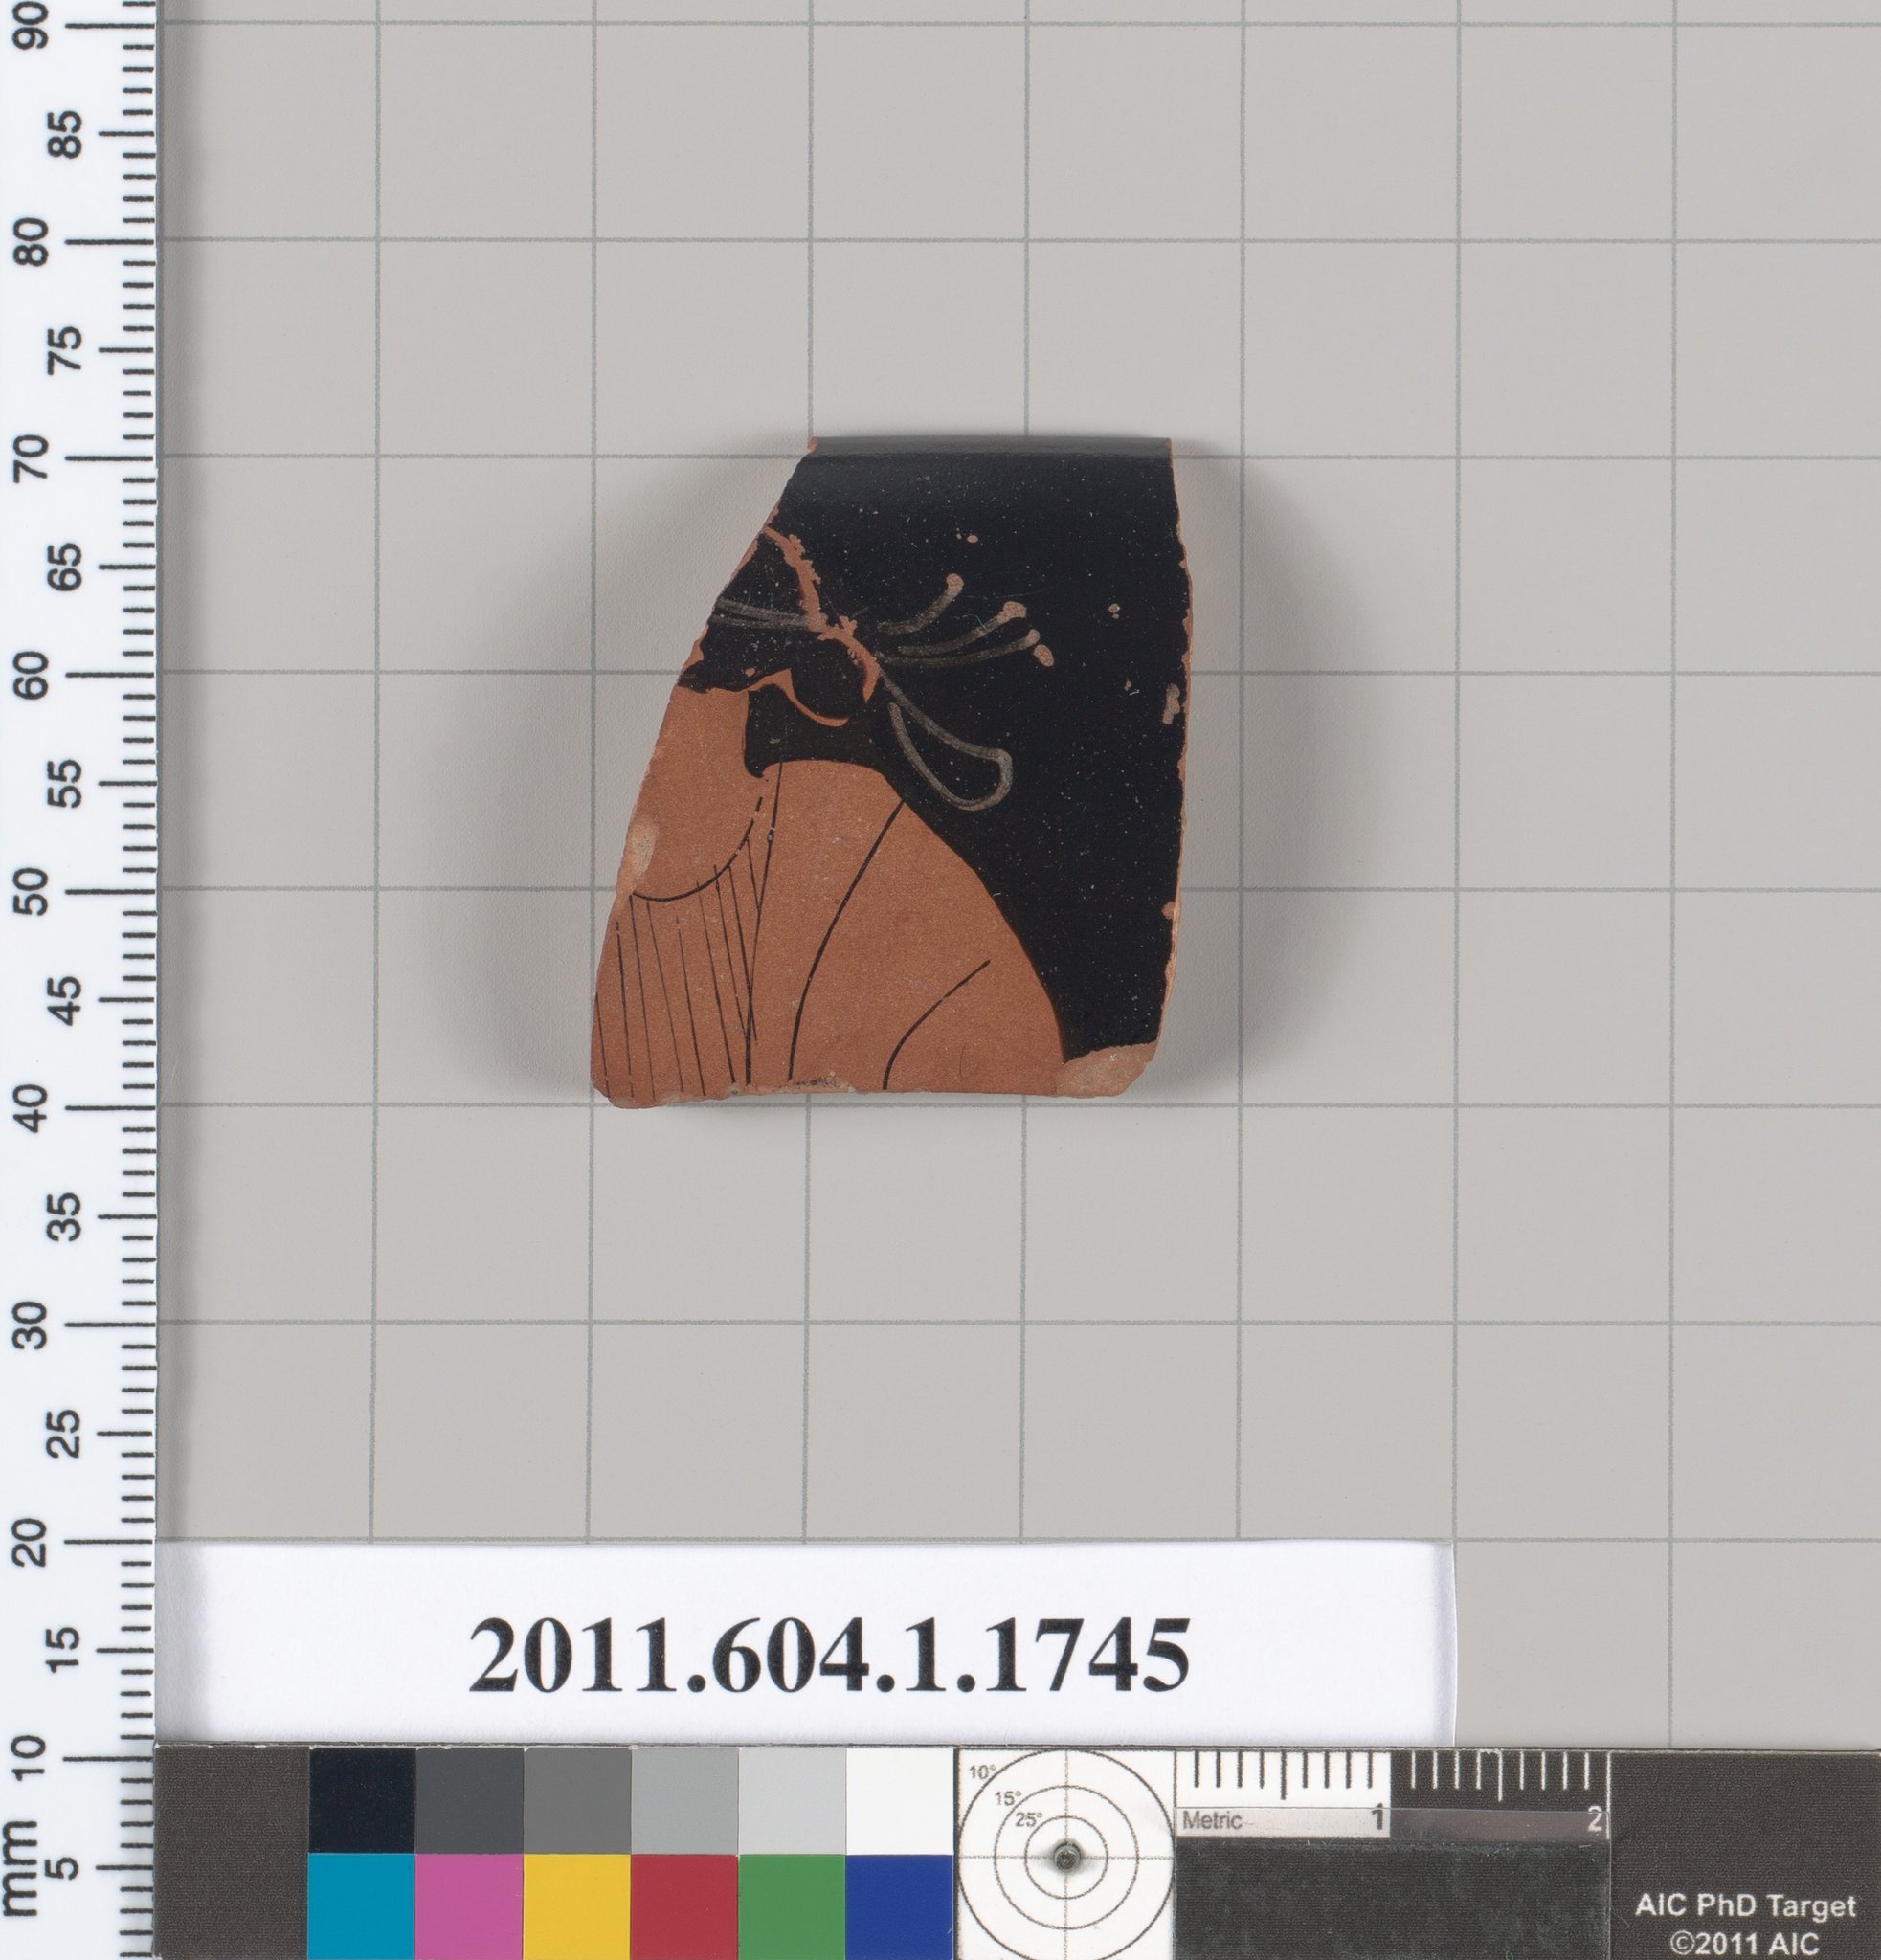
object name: kylix fragment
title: Terracotta rim fragment of a kylix (drinking cup)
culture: greek, attic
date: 475-451 BCE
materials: terracotta